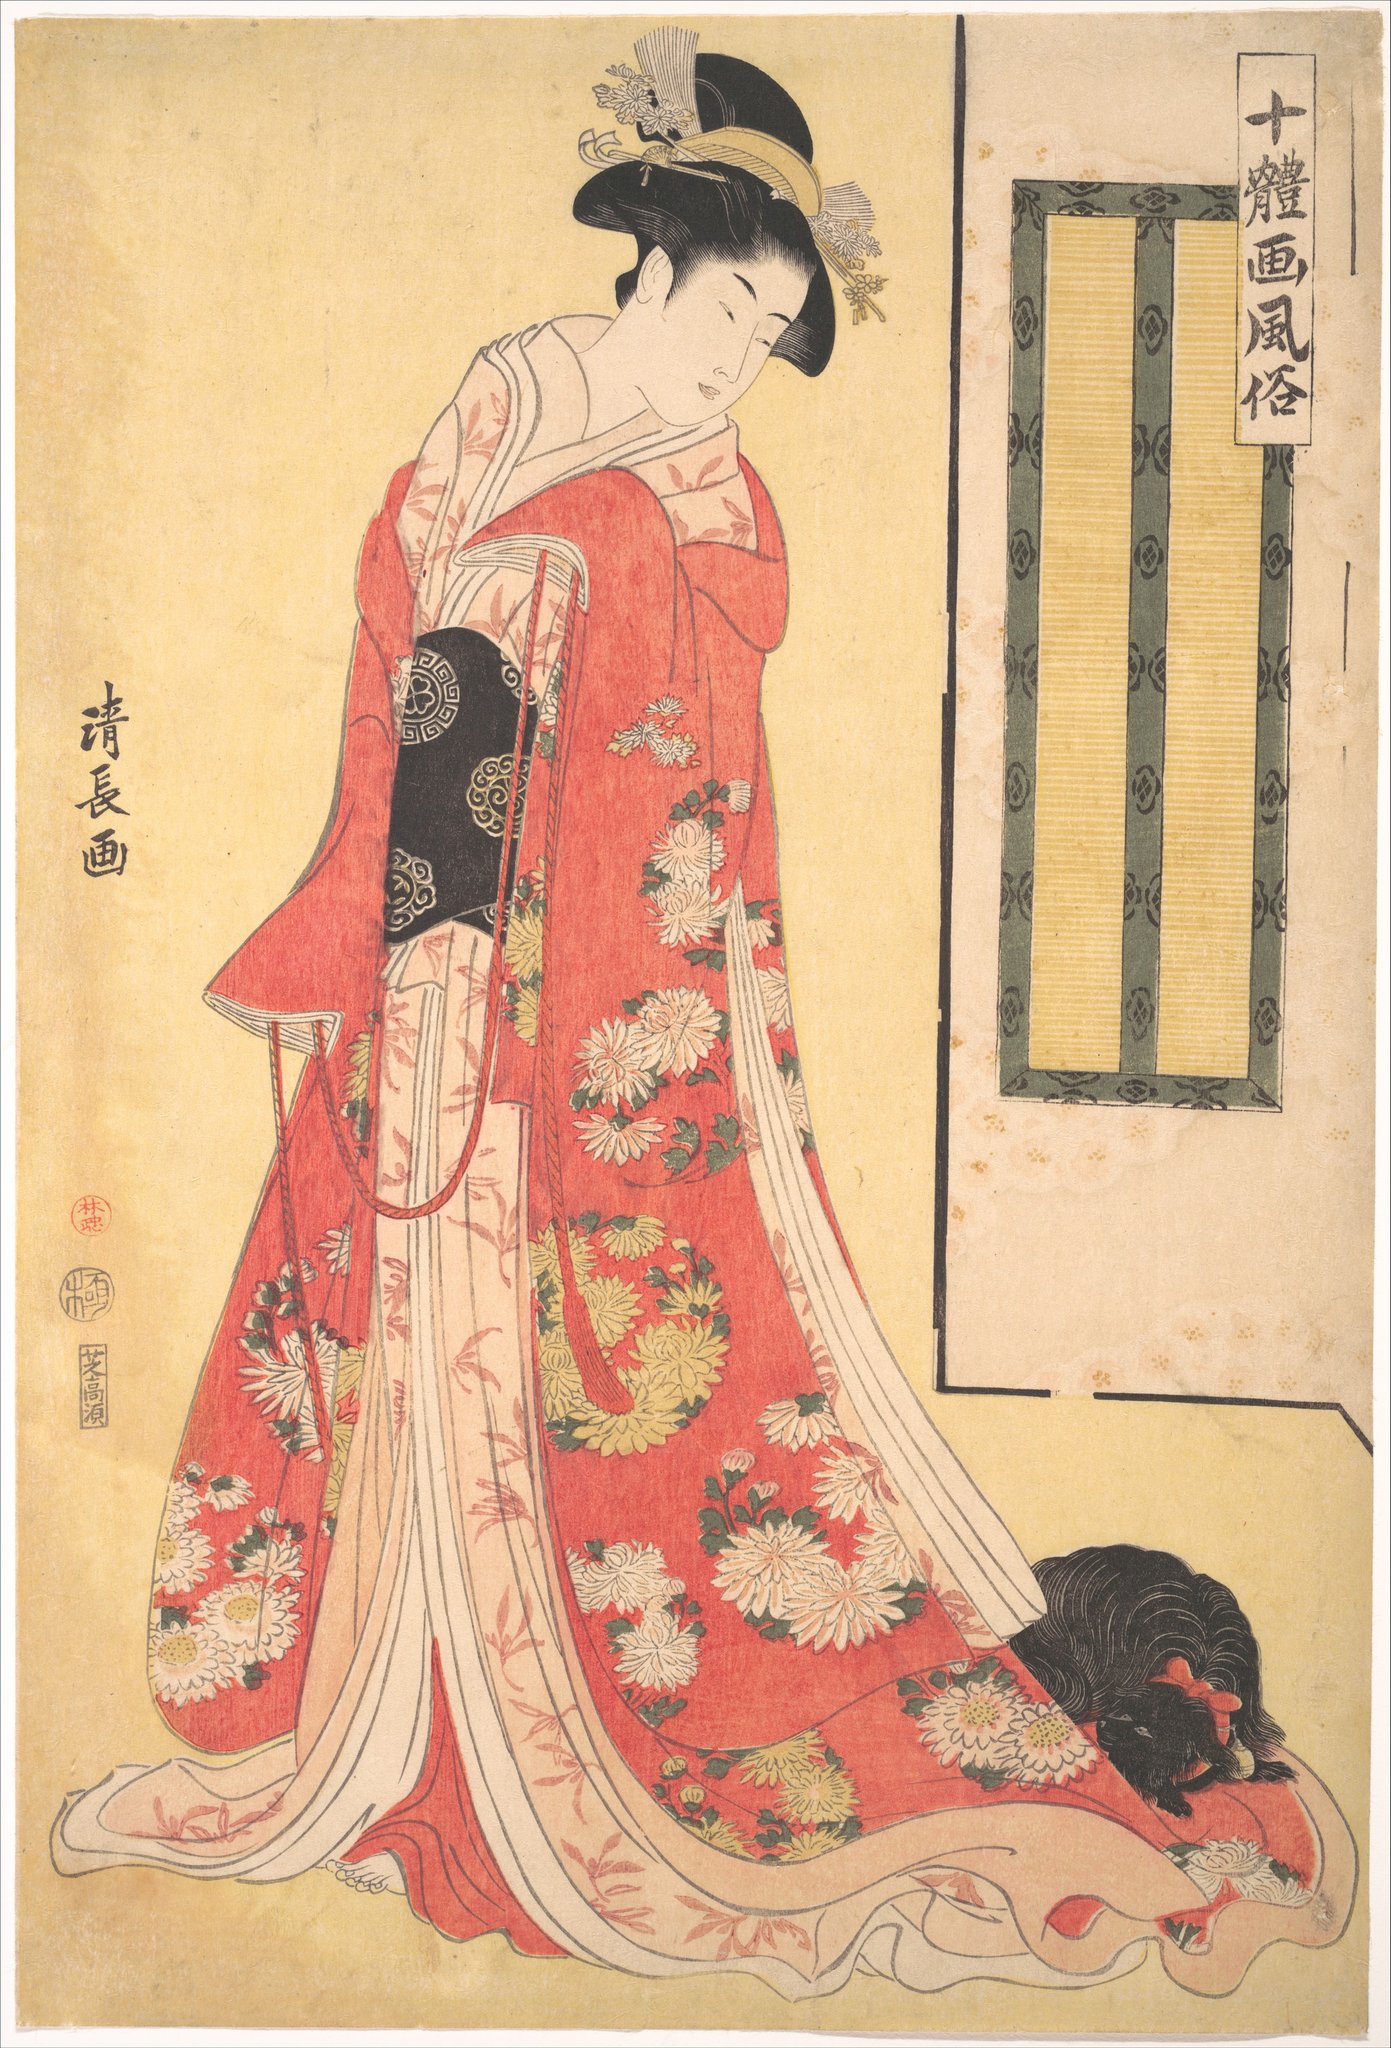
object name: print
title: Pictures of Ten Styles (Jittaiga Fuzoku): A Young Woman with a Dog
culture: japanese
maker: torii kiyonaga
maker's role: artist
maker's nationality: japanese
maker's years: 1752-1815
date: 1790-1791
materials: ink, paper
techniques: woodblock print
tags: women,dogs